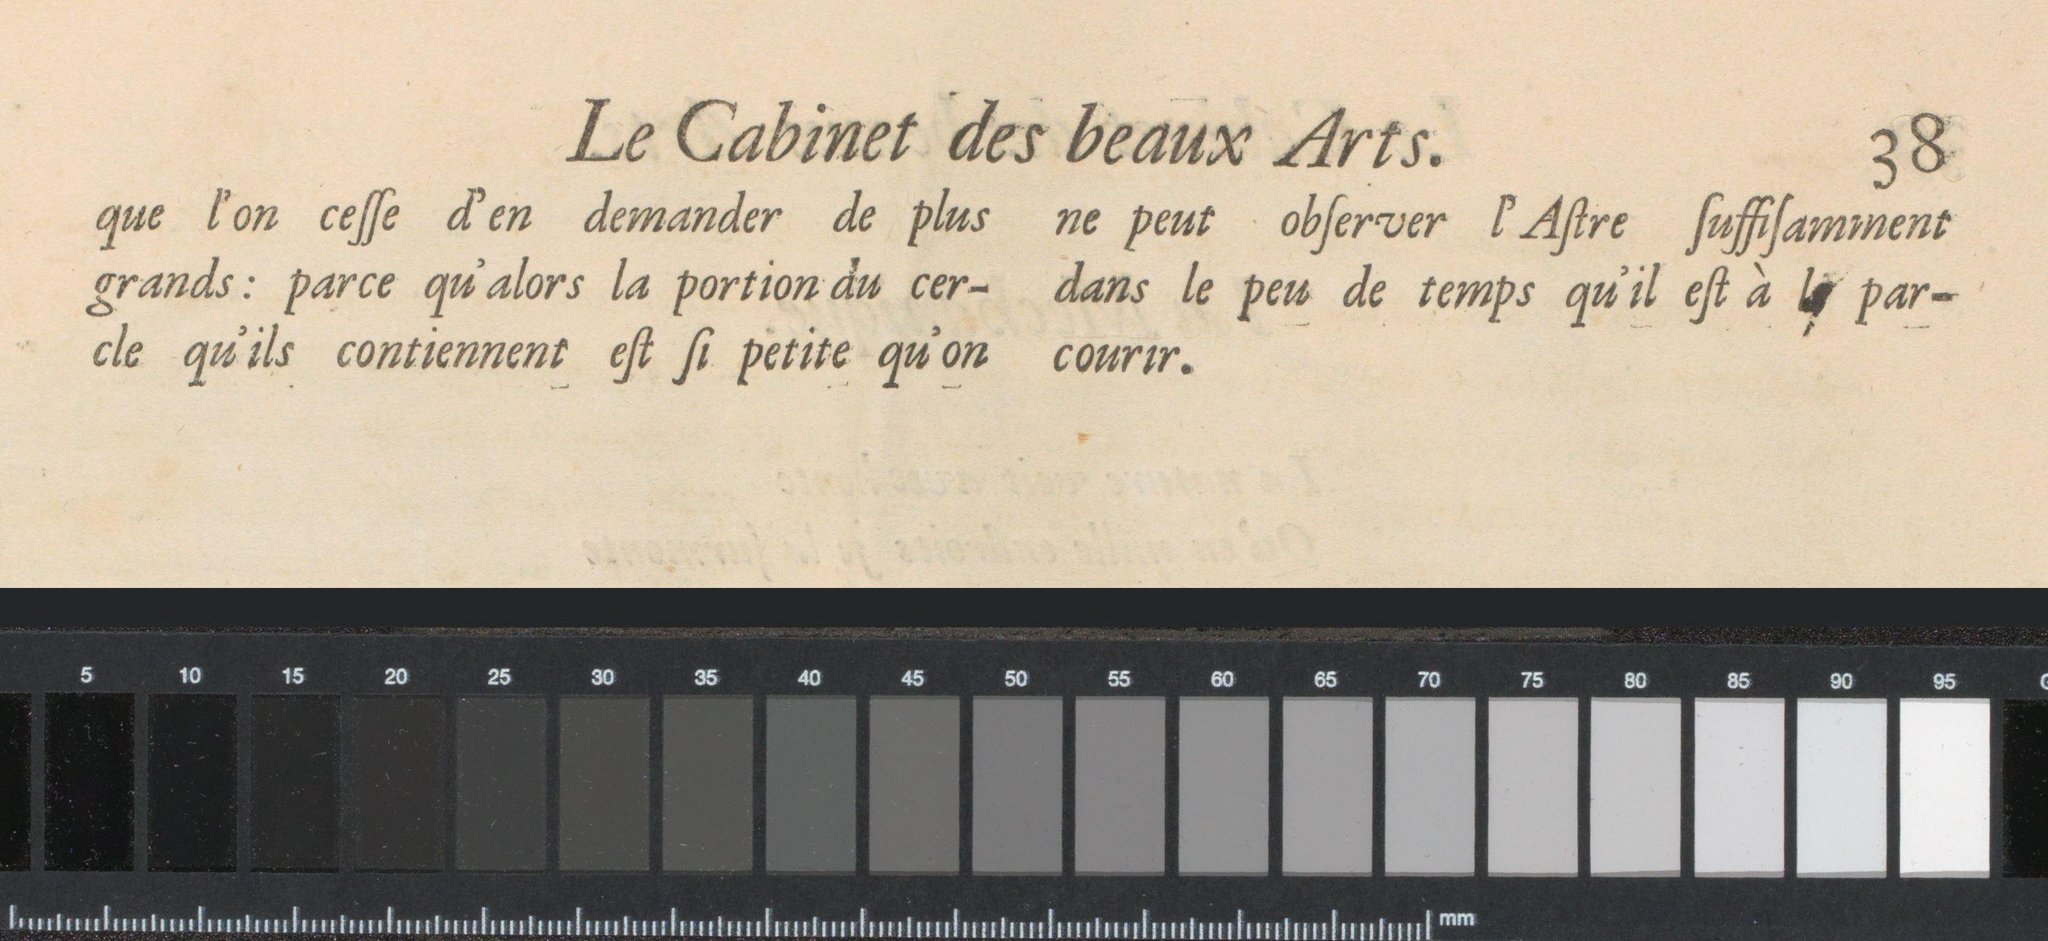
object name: text sheet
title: Tekstblad met verklaring van de prent over Zichtkunde, p. 38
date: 1695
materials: paper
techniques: letterpress printing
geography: paris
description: Verklaring van de prent met voorstelling van Zichtkunde in het Frans. Pagina 38. Tekstblad maakt deel uit van een album.